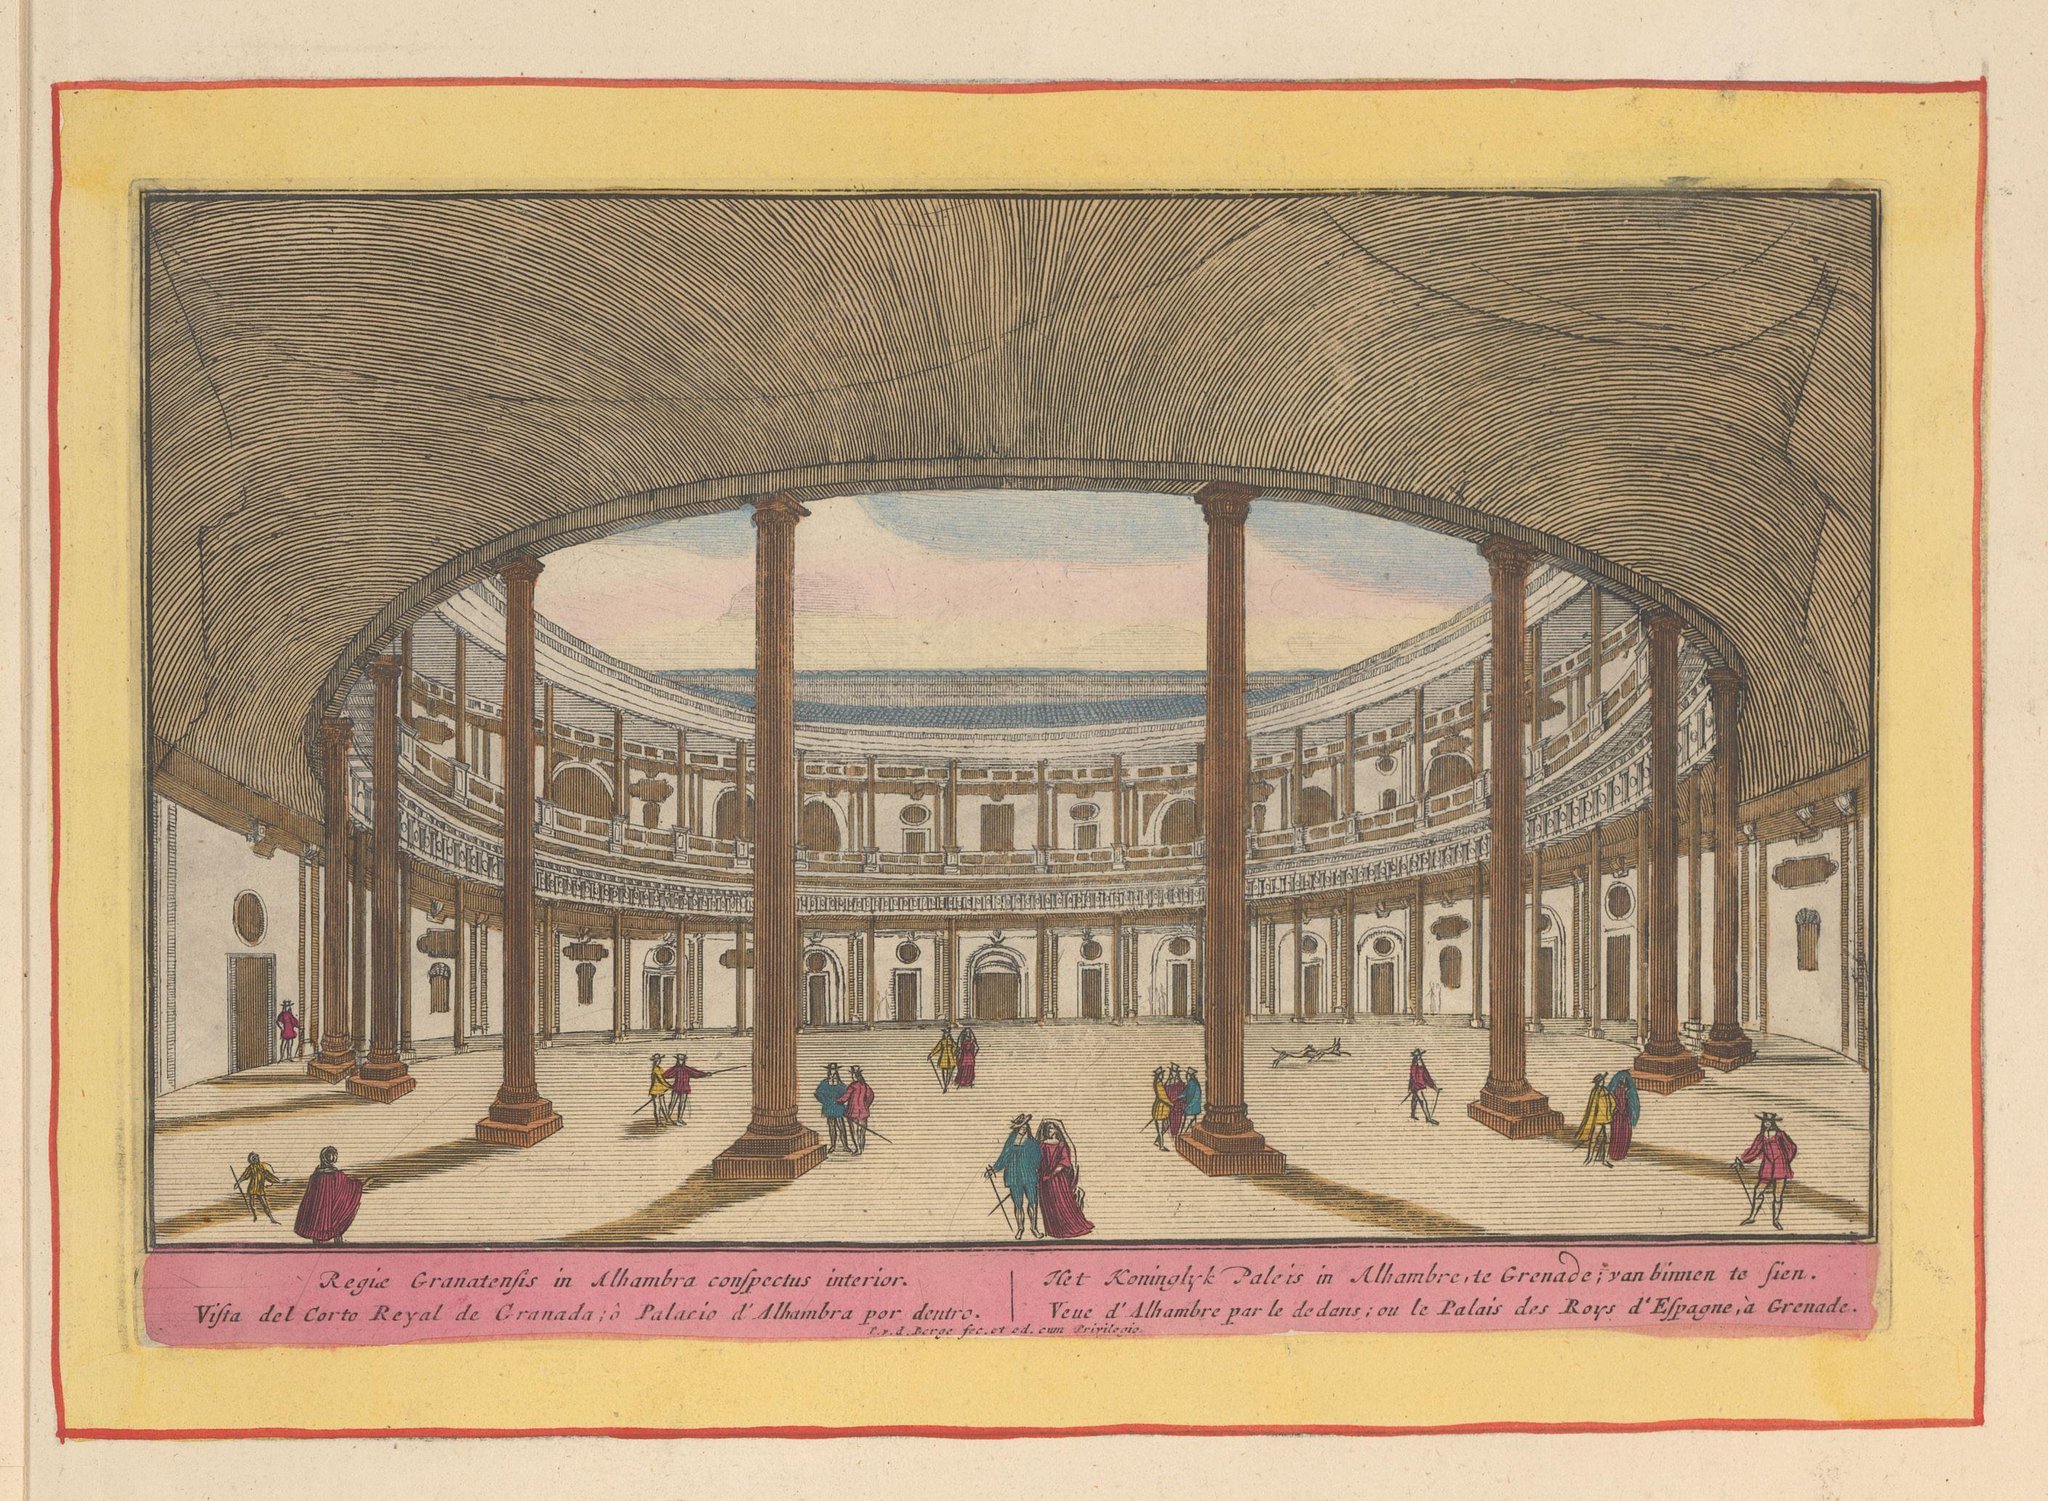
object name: album leaf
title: Theatrum Hispaniae (...)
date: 1694-1737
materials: paper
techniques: etching, hand coloring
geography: amsterdam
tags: palace, courtyard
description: Gezicht op de ronde binnenplaats van het Paleis van Karel V in het Alhambra te Granada. Onder de voorstelling een titel in het Latijn, Spaans, Nederlands en Frans. Prent maakt deel uit van een album.